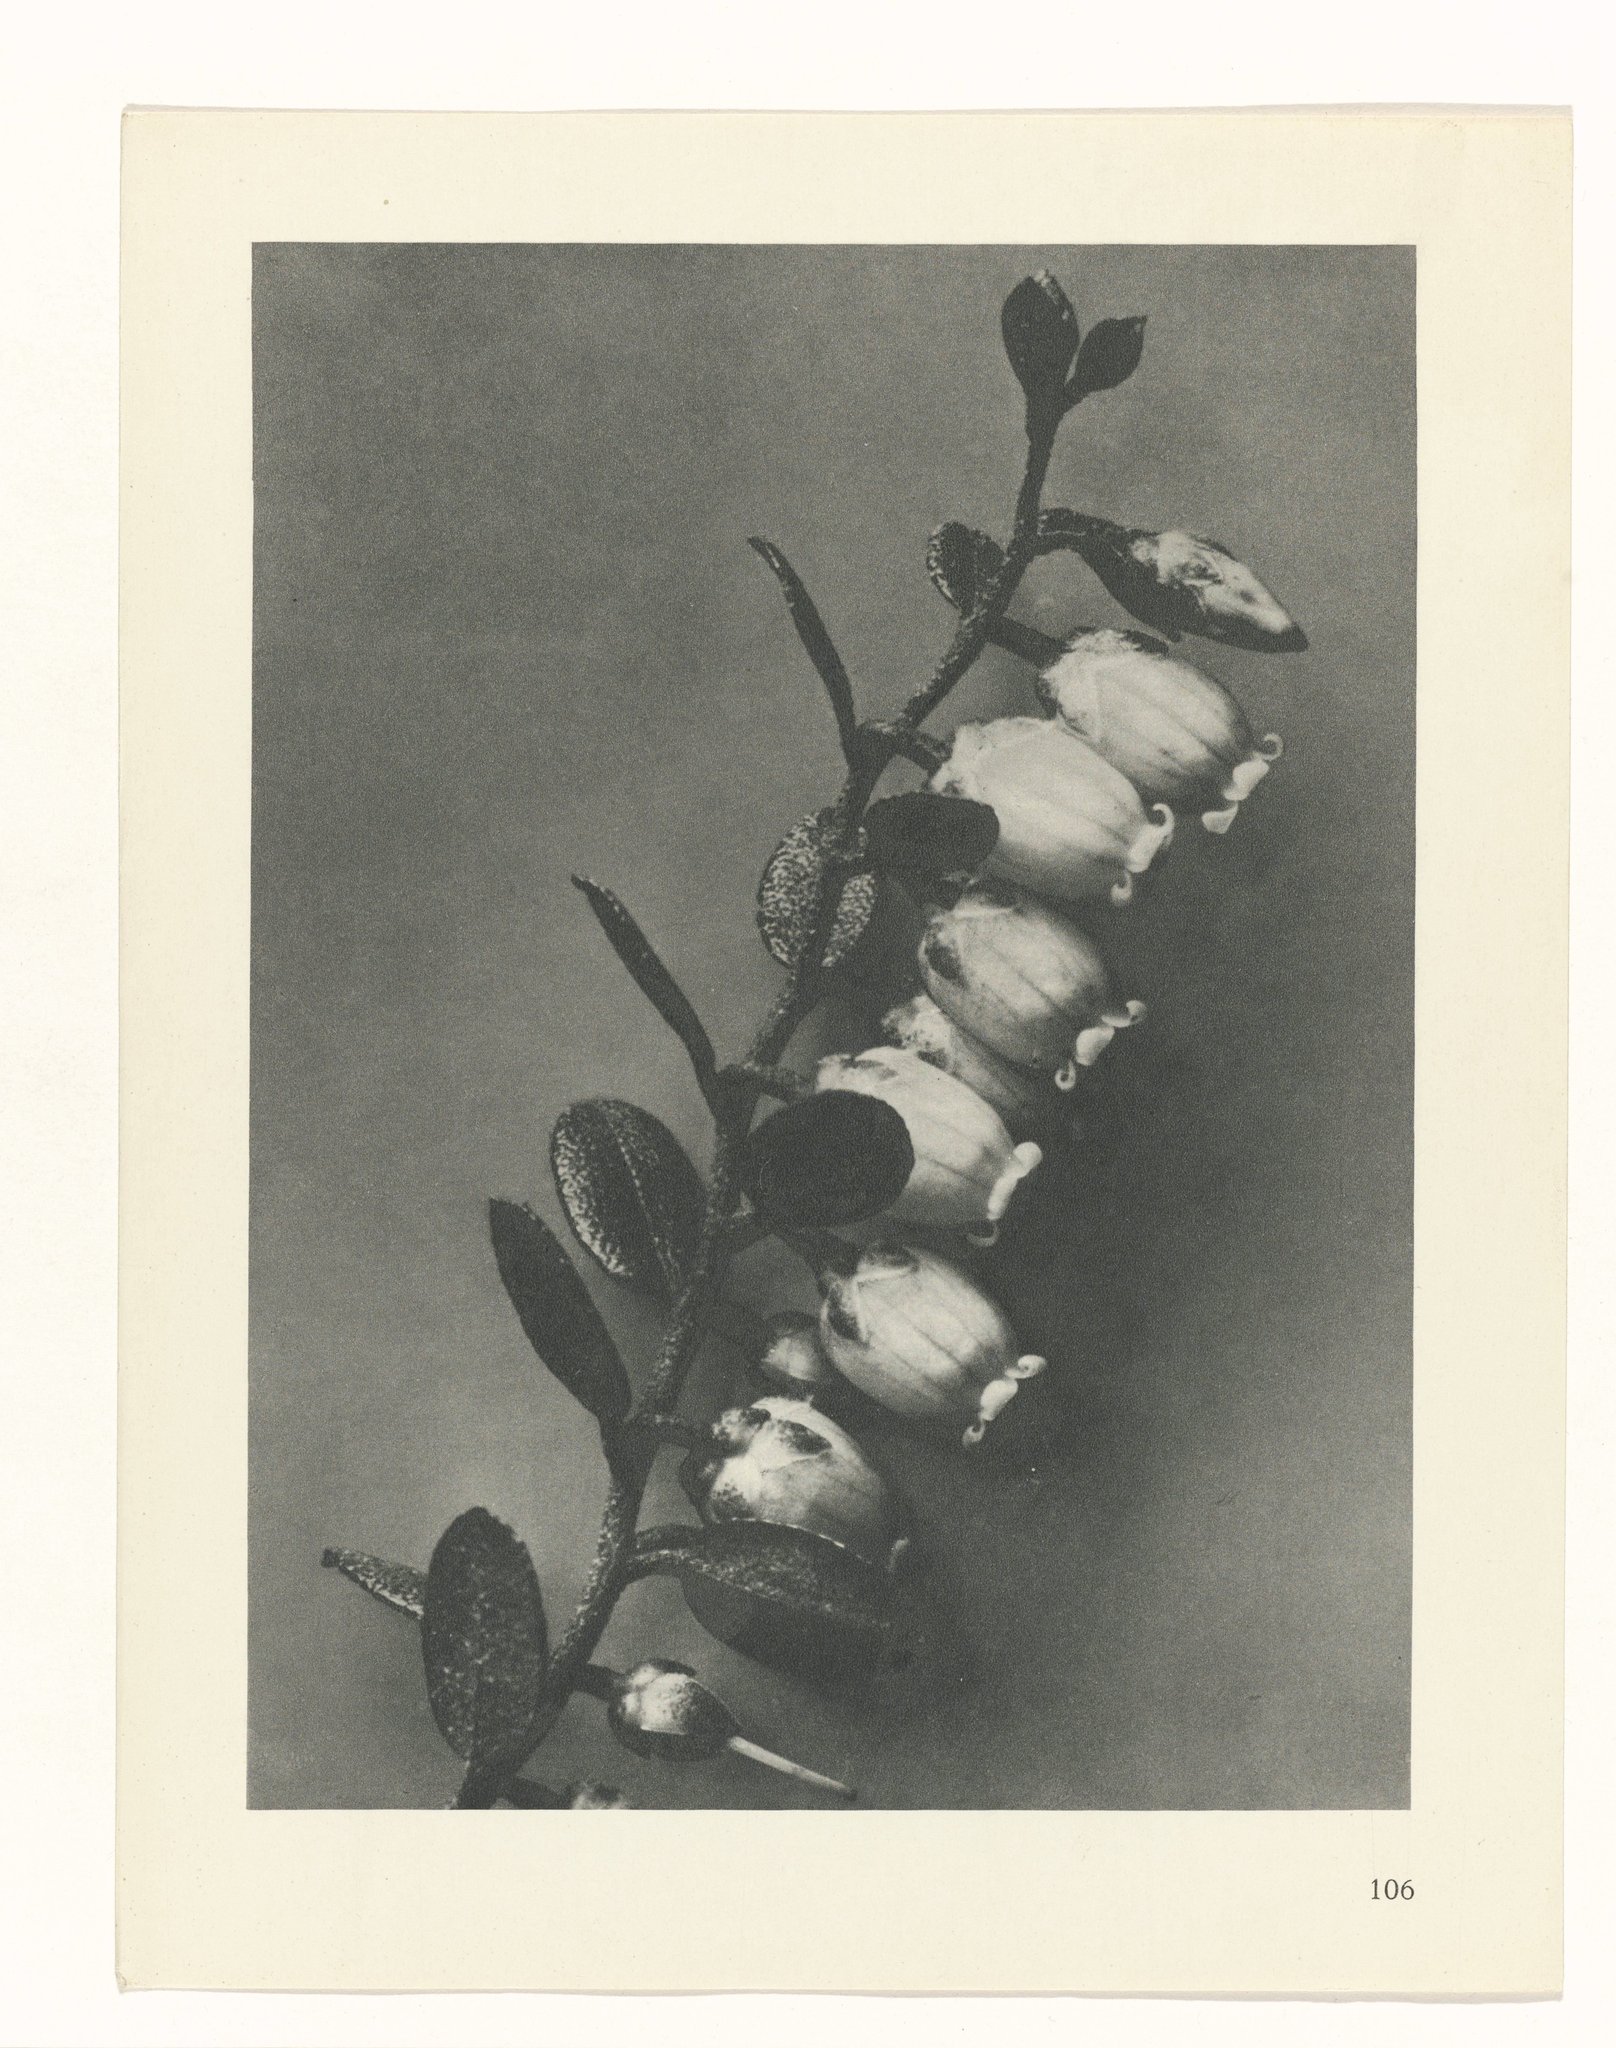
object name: photograph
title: Plantstudie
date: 1928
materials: ink, paper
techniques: rotogravure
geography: berlin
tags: plants (in general)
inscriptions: number: ‘106’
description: facher Vergrößerung. Afkomstig uit losbladige uitgave.